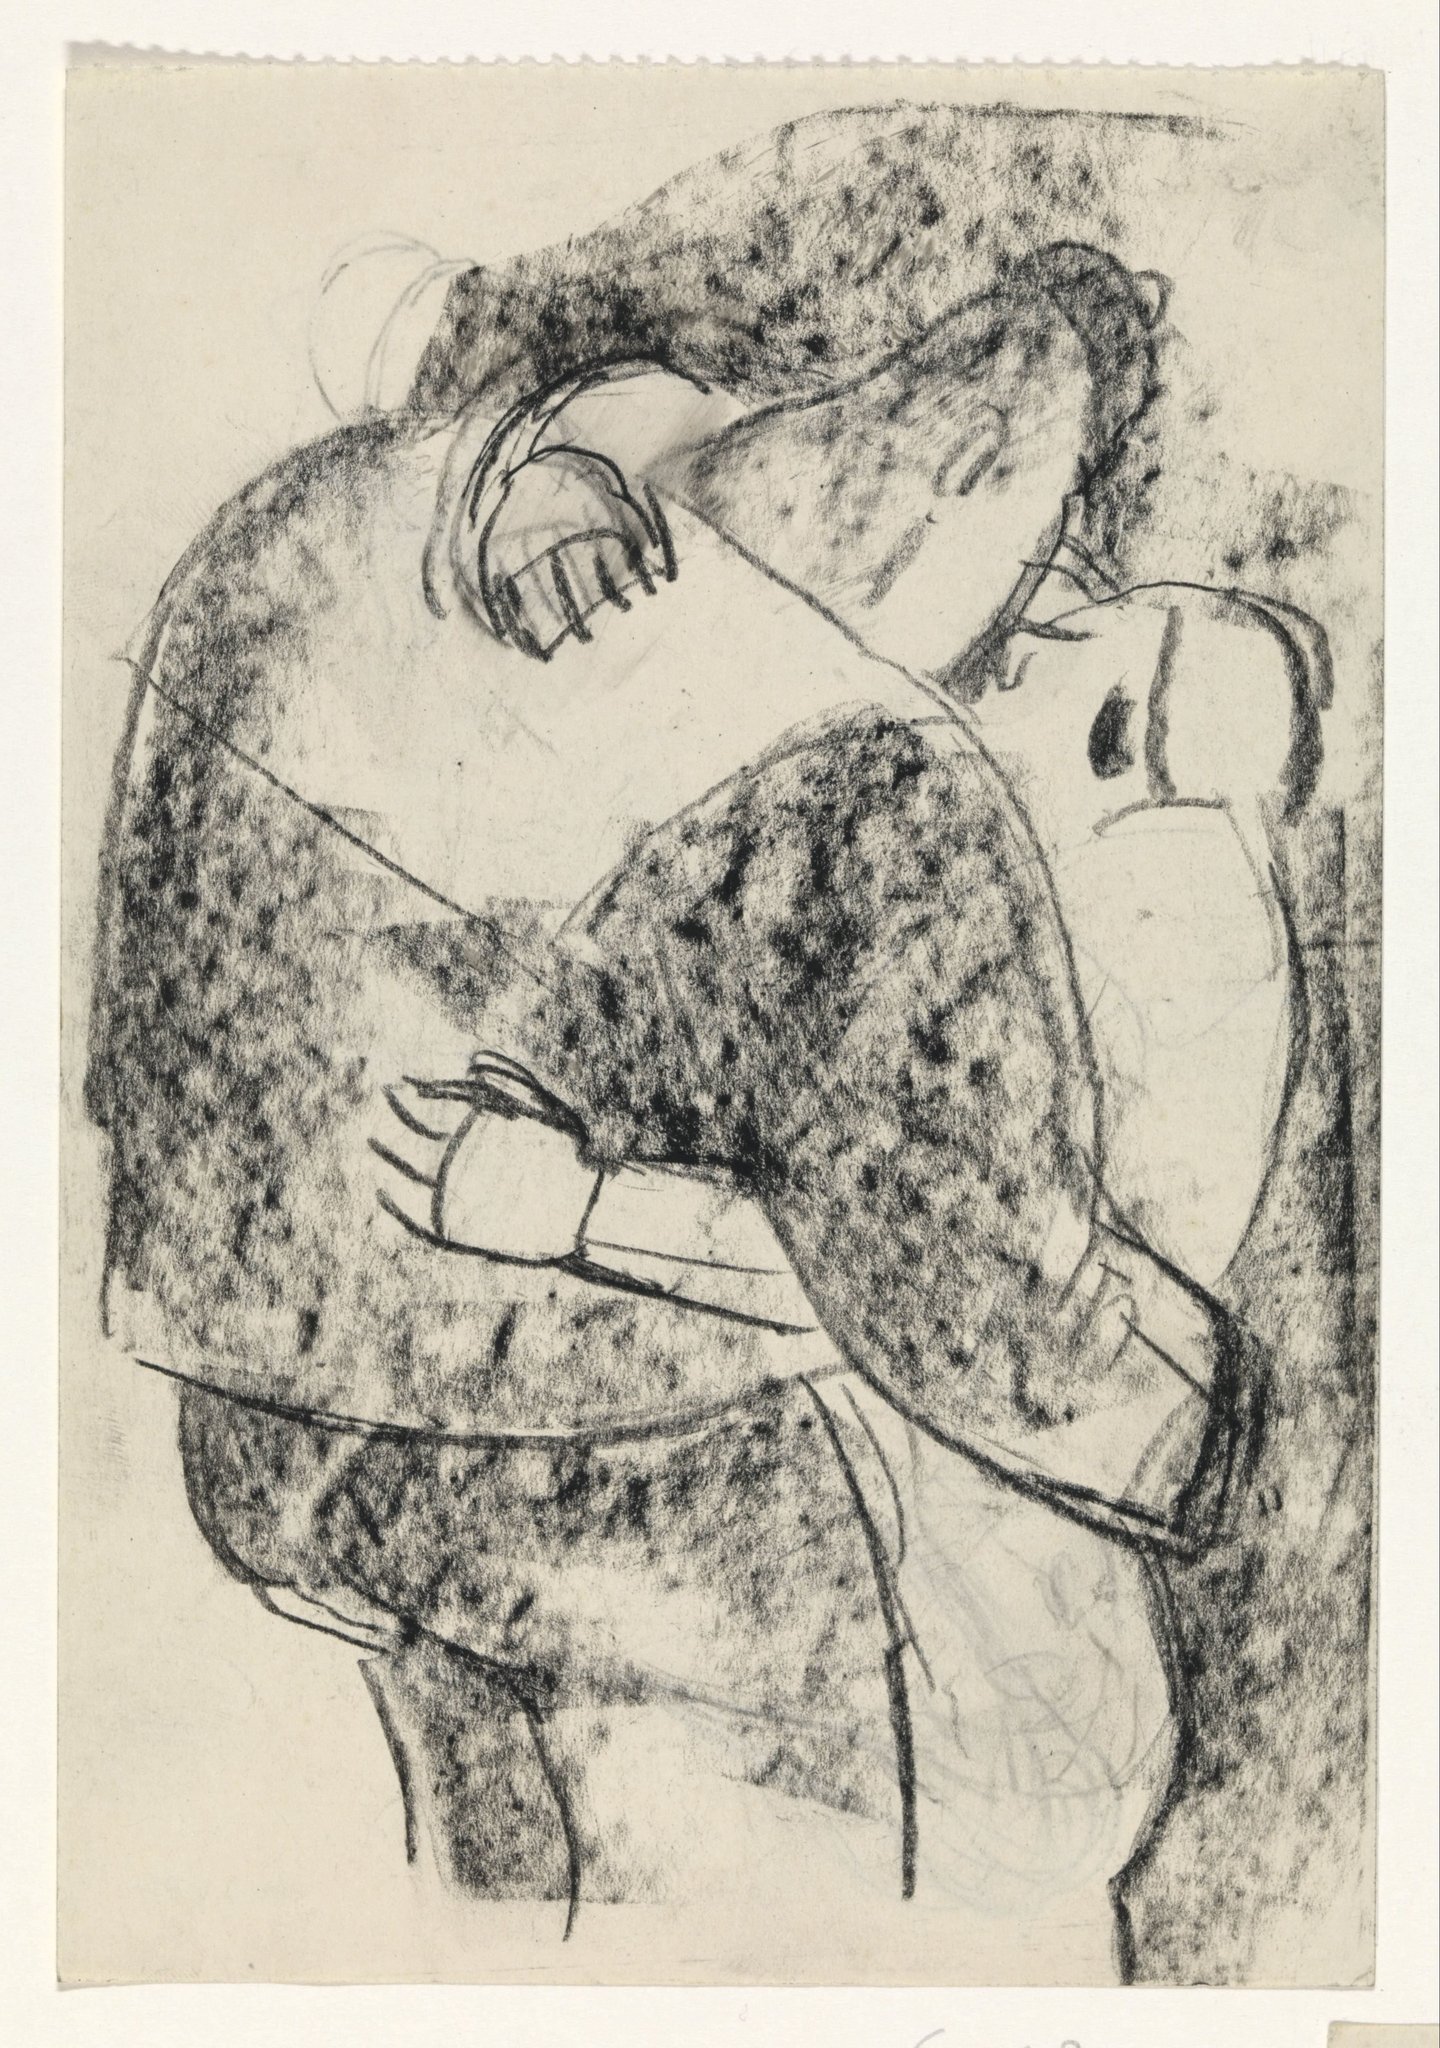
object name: drawing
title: Kussend stel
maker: leo gestel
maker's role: draughtsman, print maker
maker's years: 1881-1941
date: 1891-1941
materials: chalk, paper, pencil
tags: (lovers) kissing each other, embracing each other, kissing